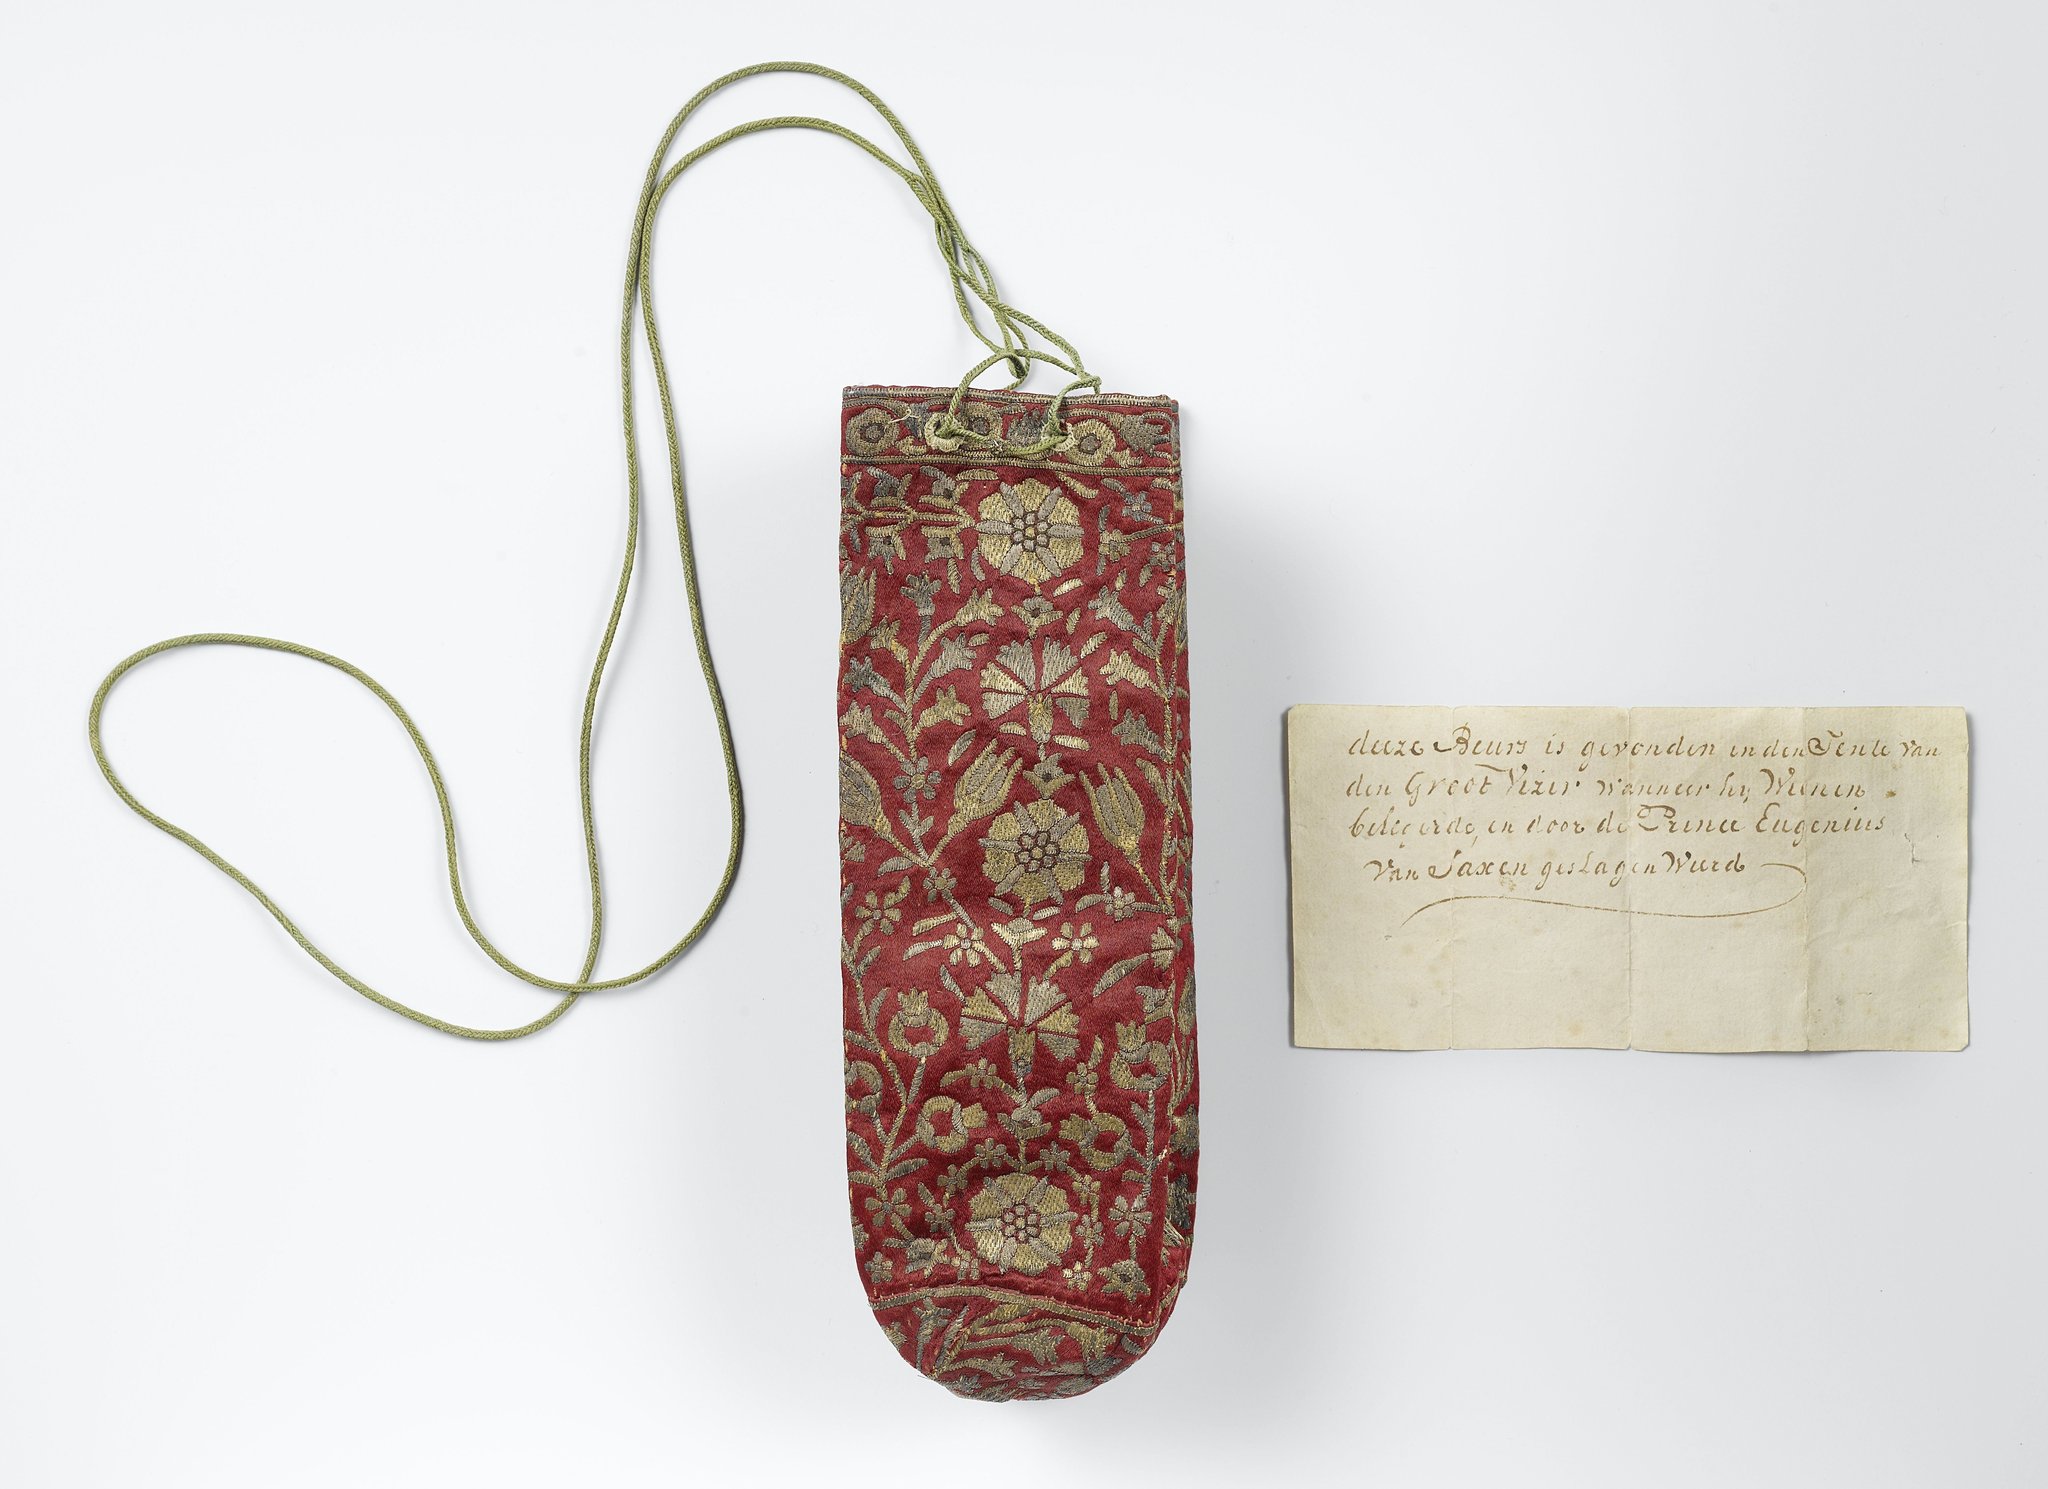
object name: purse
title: Buidel van rood satijn met floraal borduurwerk in goud- en zilverdraad, met bijgevoegd briefje met betrekking tot de vermeende herkomst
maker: Anonymous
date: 1683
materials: cotton, gold thread, linen, textile, silk, thread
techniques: braiding, embroidered, weave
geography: turkey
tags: paris, vienna, eugenius van savoye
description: Buidel of brieventas, satijn, goud- en zilverdraad, linnen, zijde, katoen Turkije, Bursa, ca. 1550-1600 Wenen, 1683 Inv. BK-1960-174 Volgens een bijgevoegd briefje, waarop met inkt is geschreven,‘deeze Beurs is gevonden in den Tente van den Groot Vizir wanneer hy Wenen belegerde en door de Prins Eugenius van Saxen geslagen wierd.’ Het laatste grote offensief van de Osmaanse Turken tegen het Westen was in 1683. Twee maanden lang belegerden zij, onder leiding van Grootvizier Kara Mustafa (1620/30-1683), met 300.000 man de stad Wenen. Door een manoeuvre van het Pools-Duitse leger moesten de Turken zich in alle haast terugtrekken met achterlating van hun tenten en persoonlijke bezittingen. Bij terugkomst in Turkije werd Kara Mustafa vanwege deze nederlaag terechtgesteld.